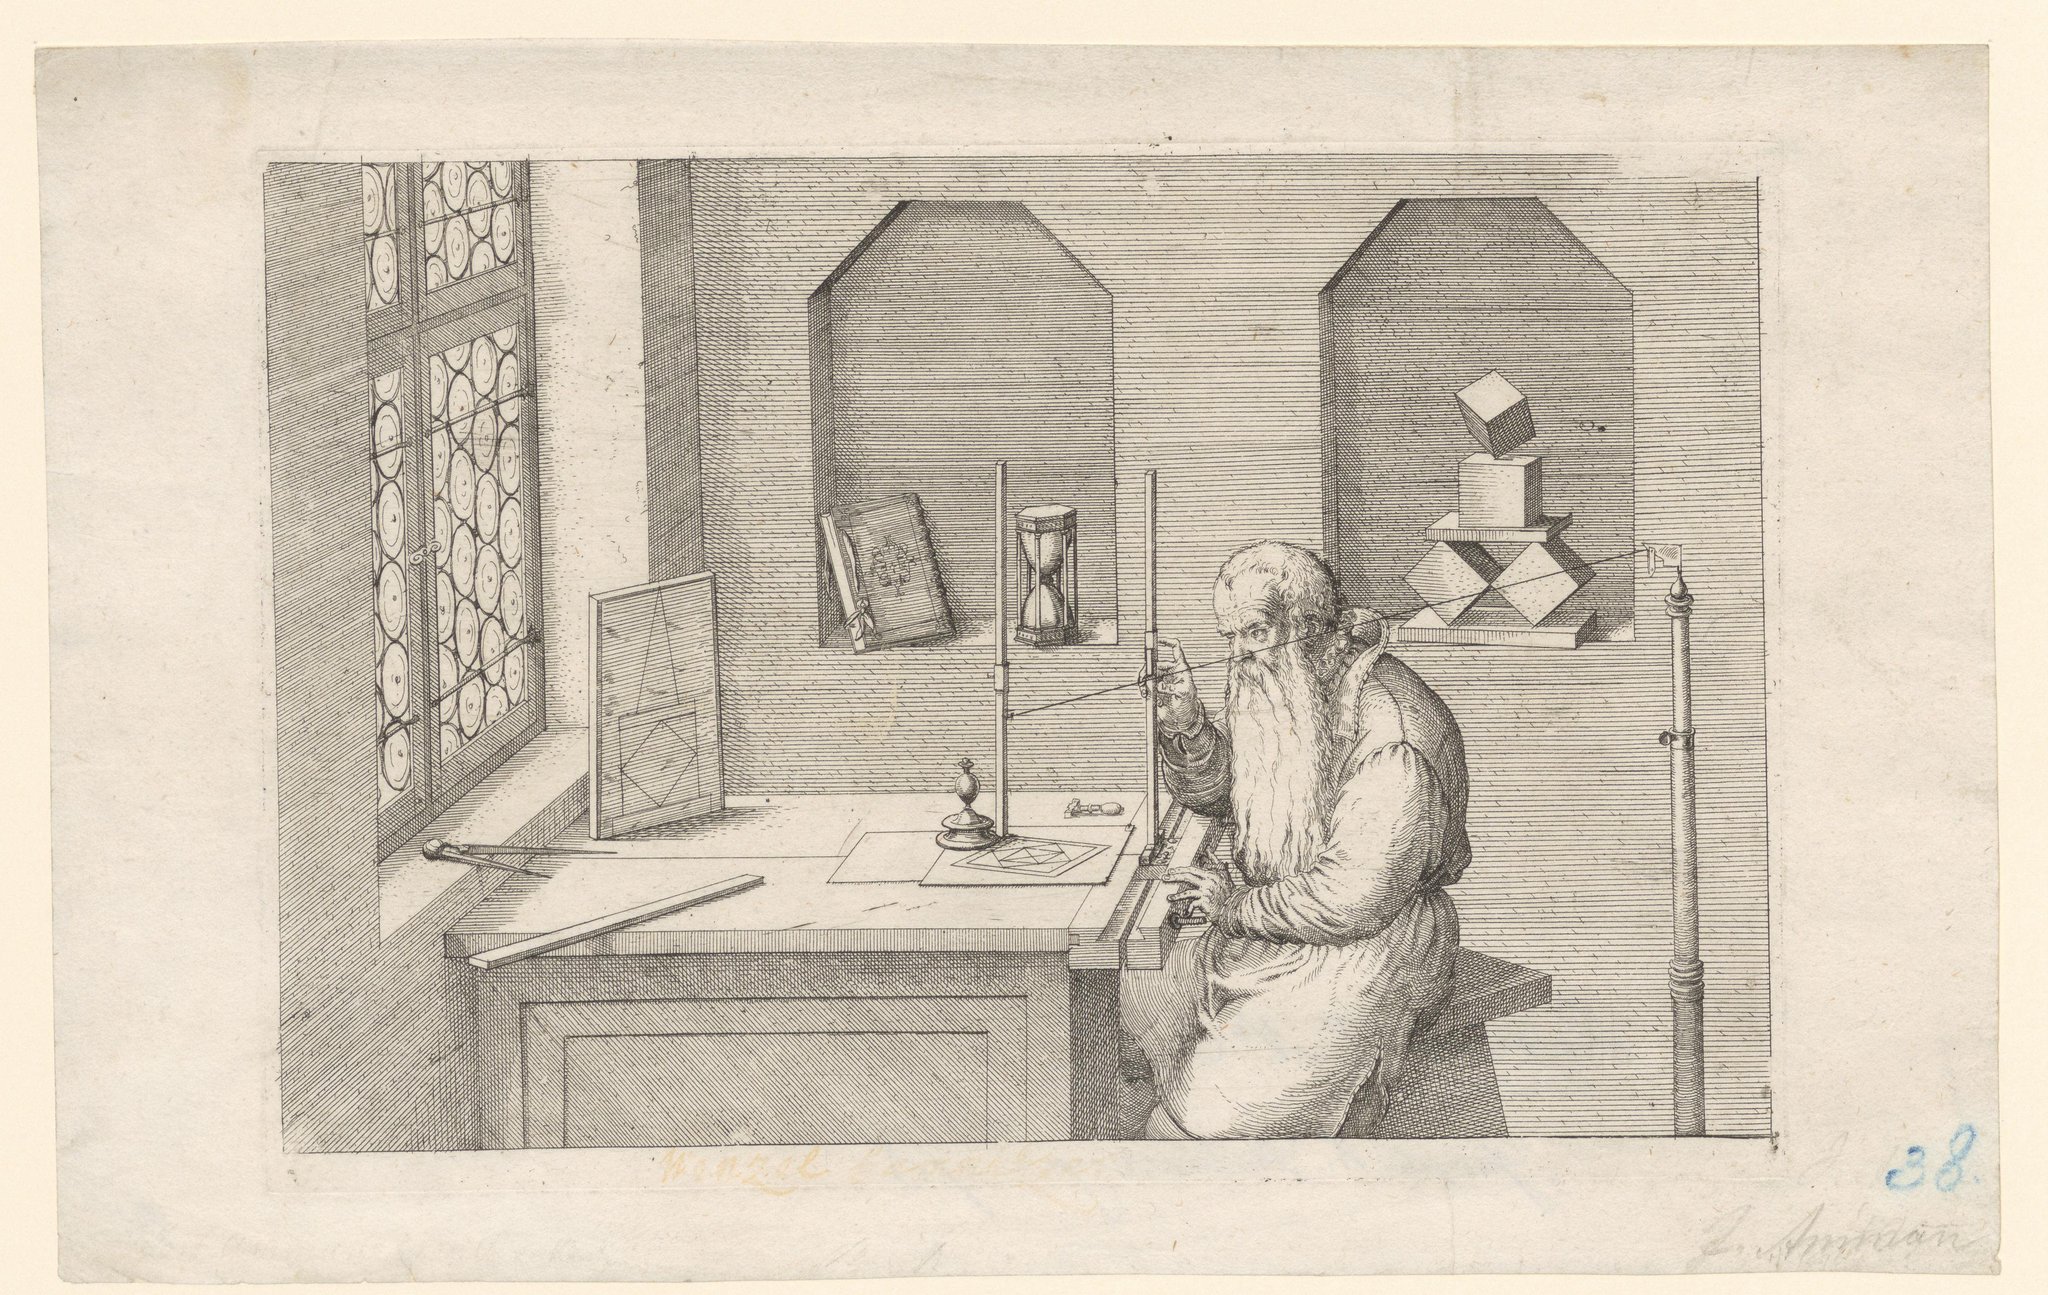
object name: print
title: Portret van Wenzel Jamnitzer, bezig met perspectivische berekeningen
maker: jost amman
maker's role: draughtsman, painter, print maker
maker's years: 1539-1591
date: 1561-1591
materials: paper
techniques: etching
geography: nuremberg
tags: vienna, wenzel jamnitzer, instruments for perspective drawing, portrait, self-portrait of craftsman in applied arts, mathematics (+ portrait of scholar, scientist)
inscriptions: collector's mark: Lugt 2228, collector's mark: Lugt 2760, inscription: ‘Menzel Jamnitzer’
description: Goud- en zilversmeden werden in de 16de eeuw vaak afgebeeld met het gereedschap dat duidt op hun vak. Wenzel Jamnitzer is hier echter geportretteerd als geleerde*, met objecten die verwijzen naar zijn wetenschappelijke belangstelling voor de leer van het perspectief*. Met deze tak van wetenschap heeft hij zich ook in werkelijkheid beziggehouden. Hij ontwikkelde het instrument voor het perspectivisch tekenen, dat hij hier demonstreert, en gaf in 1568 zijn "Perspectiva corporum regularium" uit.